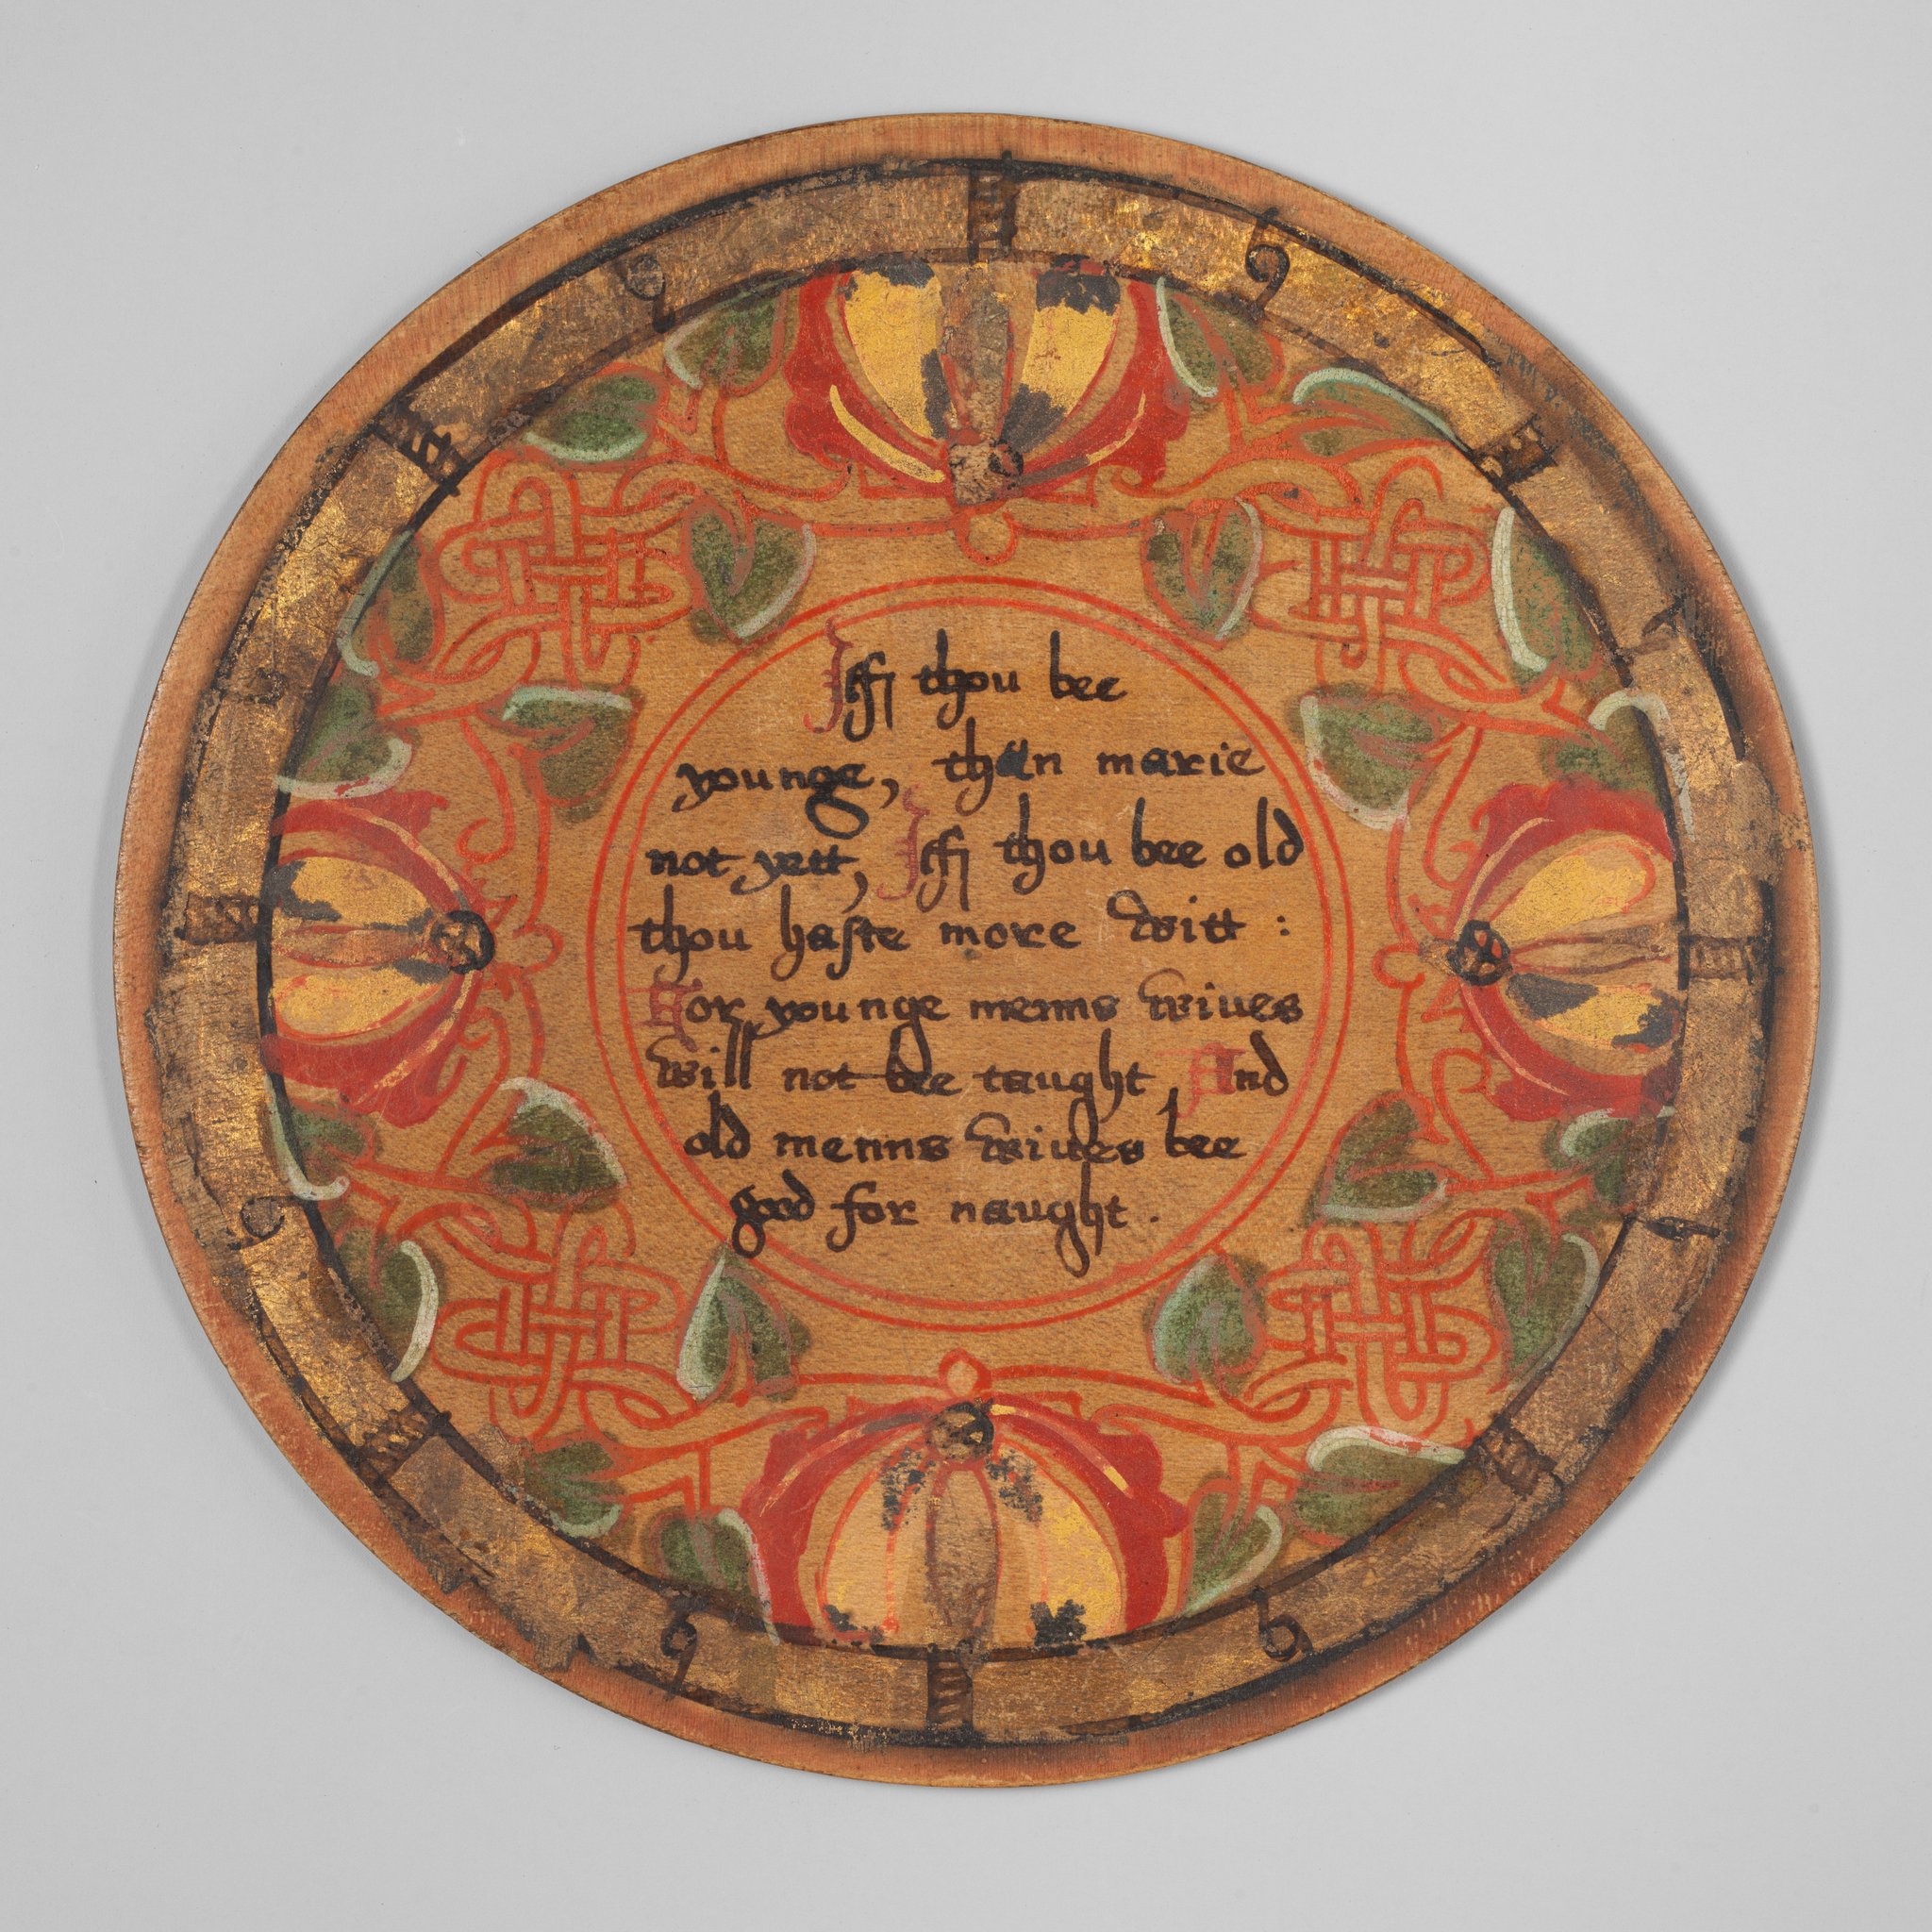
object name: trencher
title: Trencher (one of a set)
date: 1534-1566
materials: ink, wood, varnish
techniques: painting, silvered